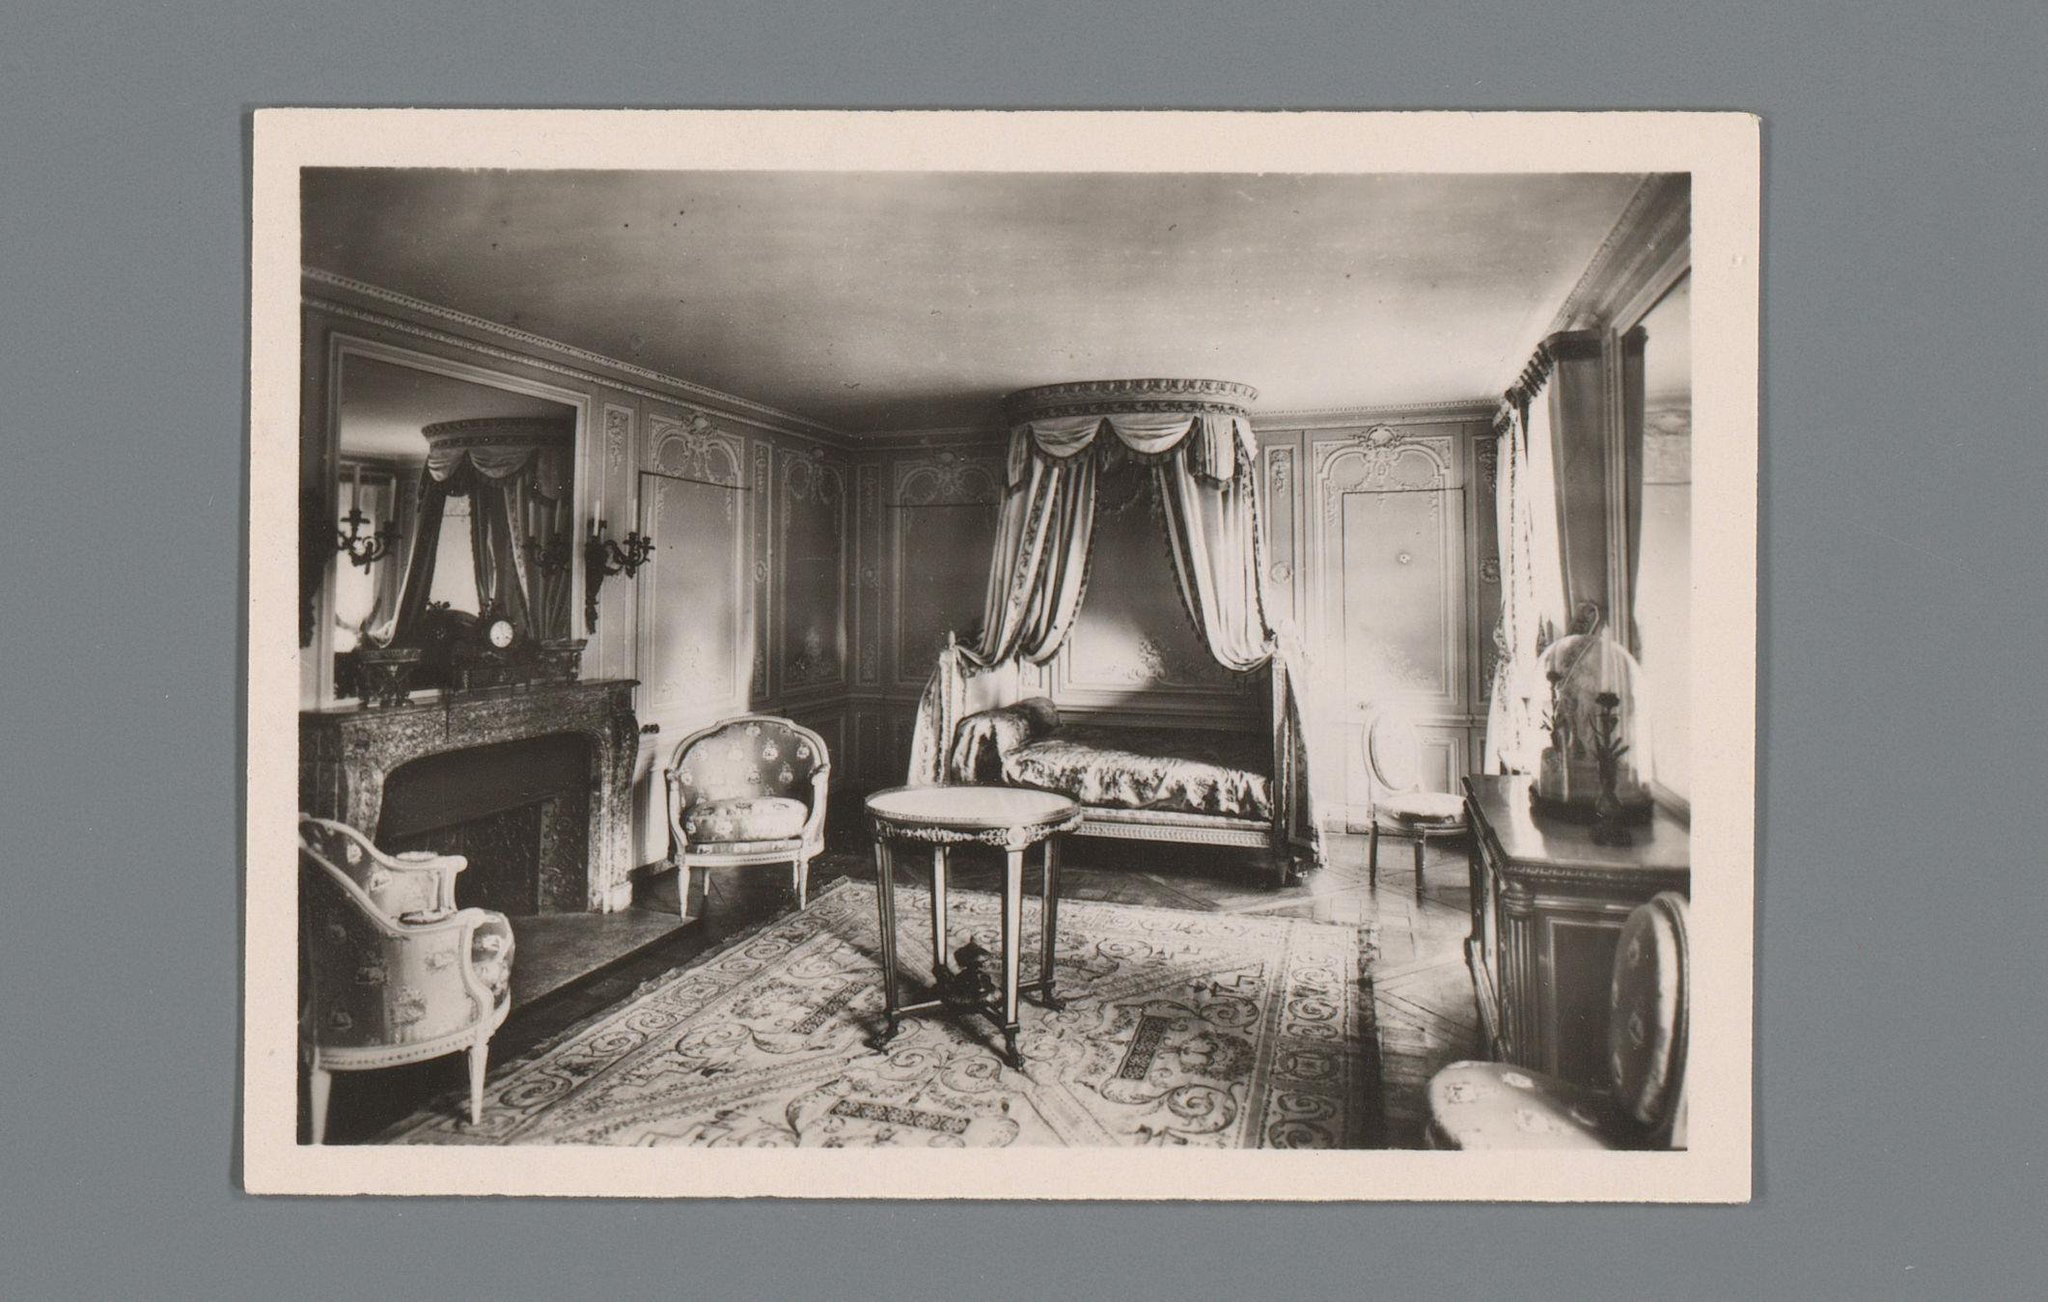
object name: photograph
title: Versailles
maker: Anonymous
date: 1900-1920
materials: paper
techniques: gelatin silver print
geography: versailles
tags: bedroom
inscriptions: number: ‘16’